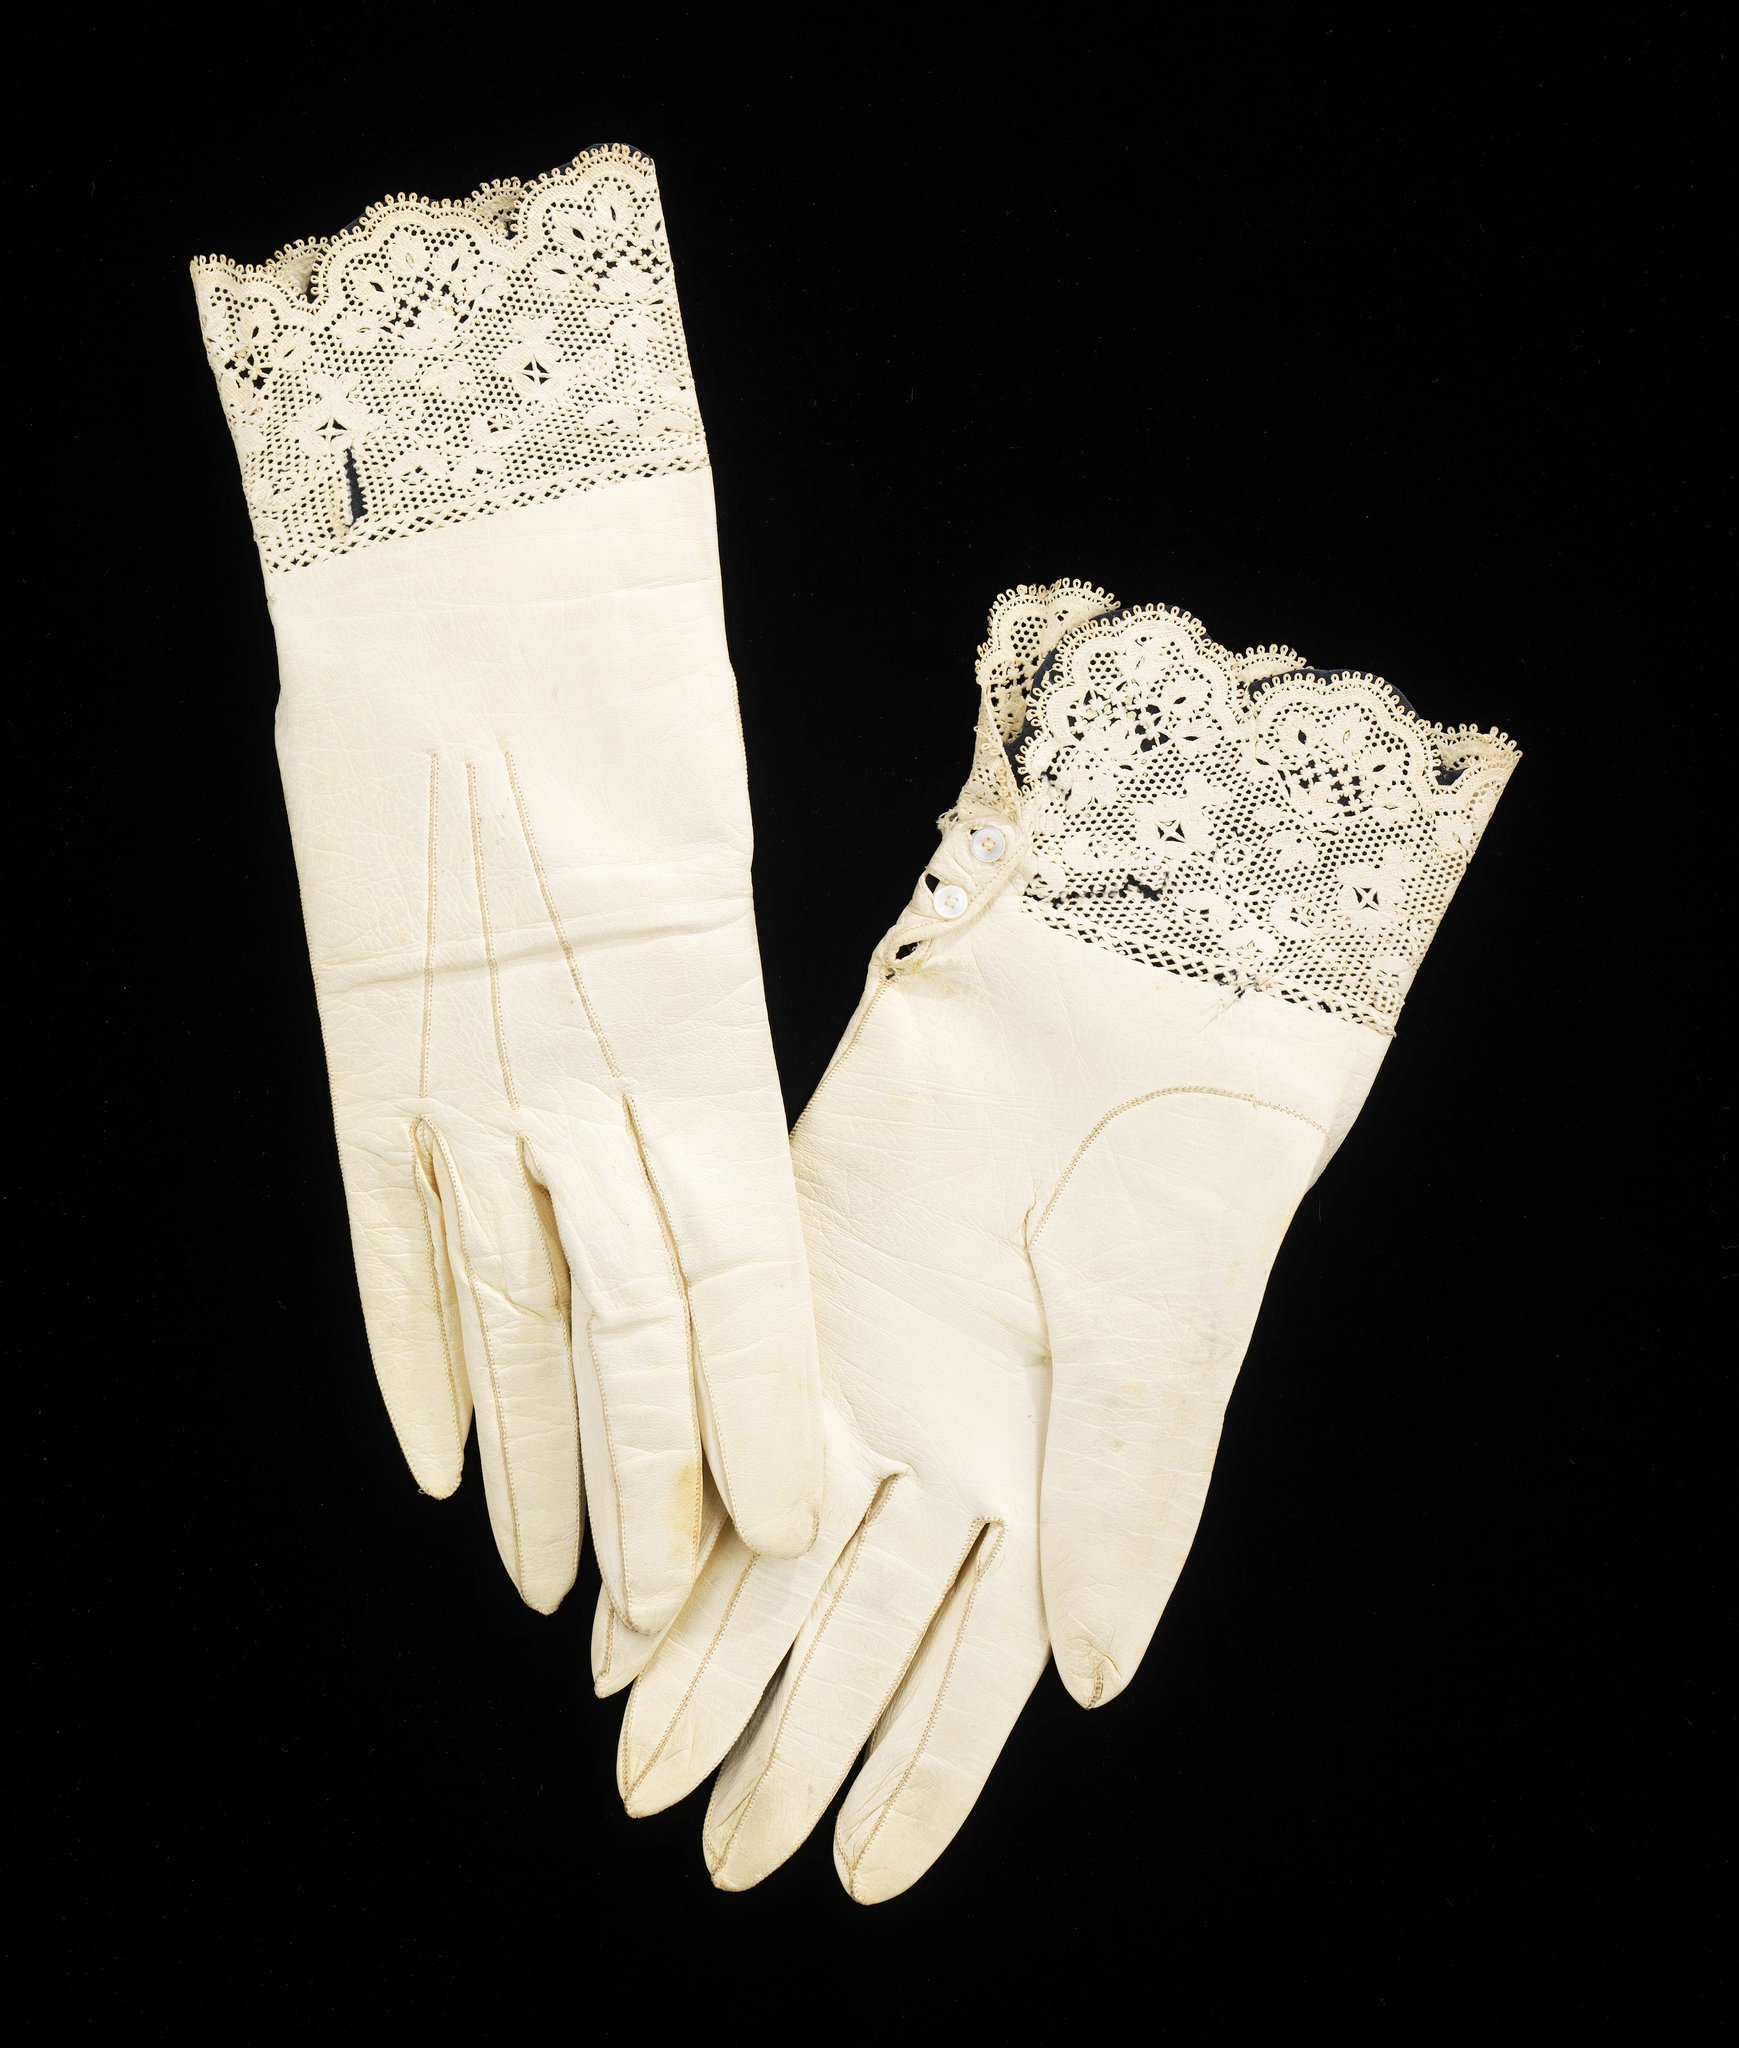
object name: wedding glove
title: Wedding gloves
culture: french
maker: préville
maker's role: manufacturer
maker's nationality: french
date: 1842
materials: leather